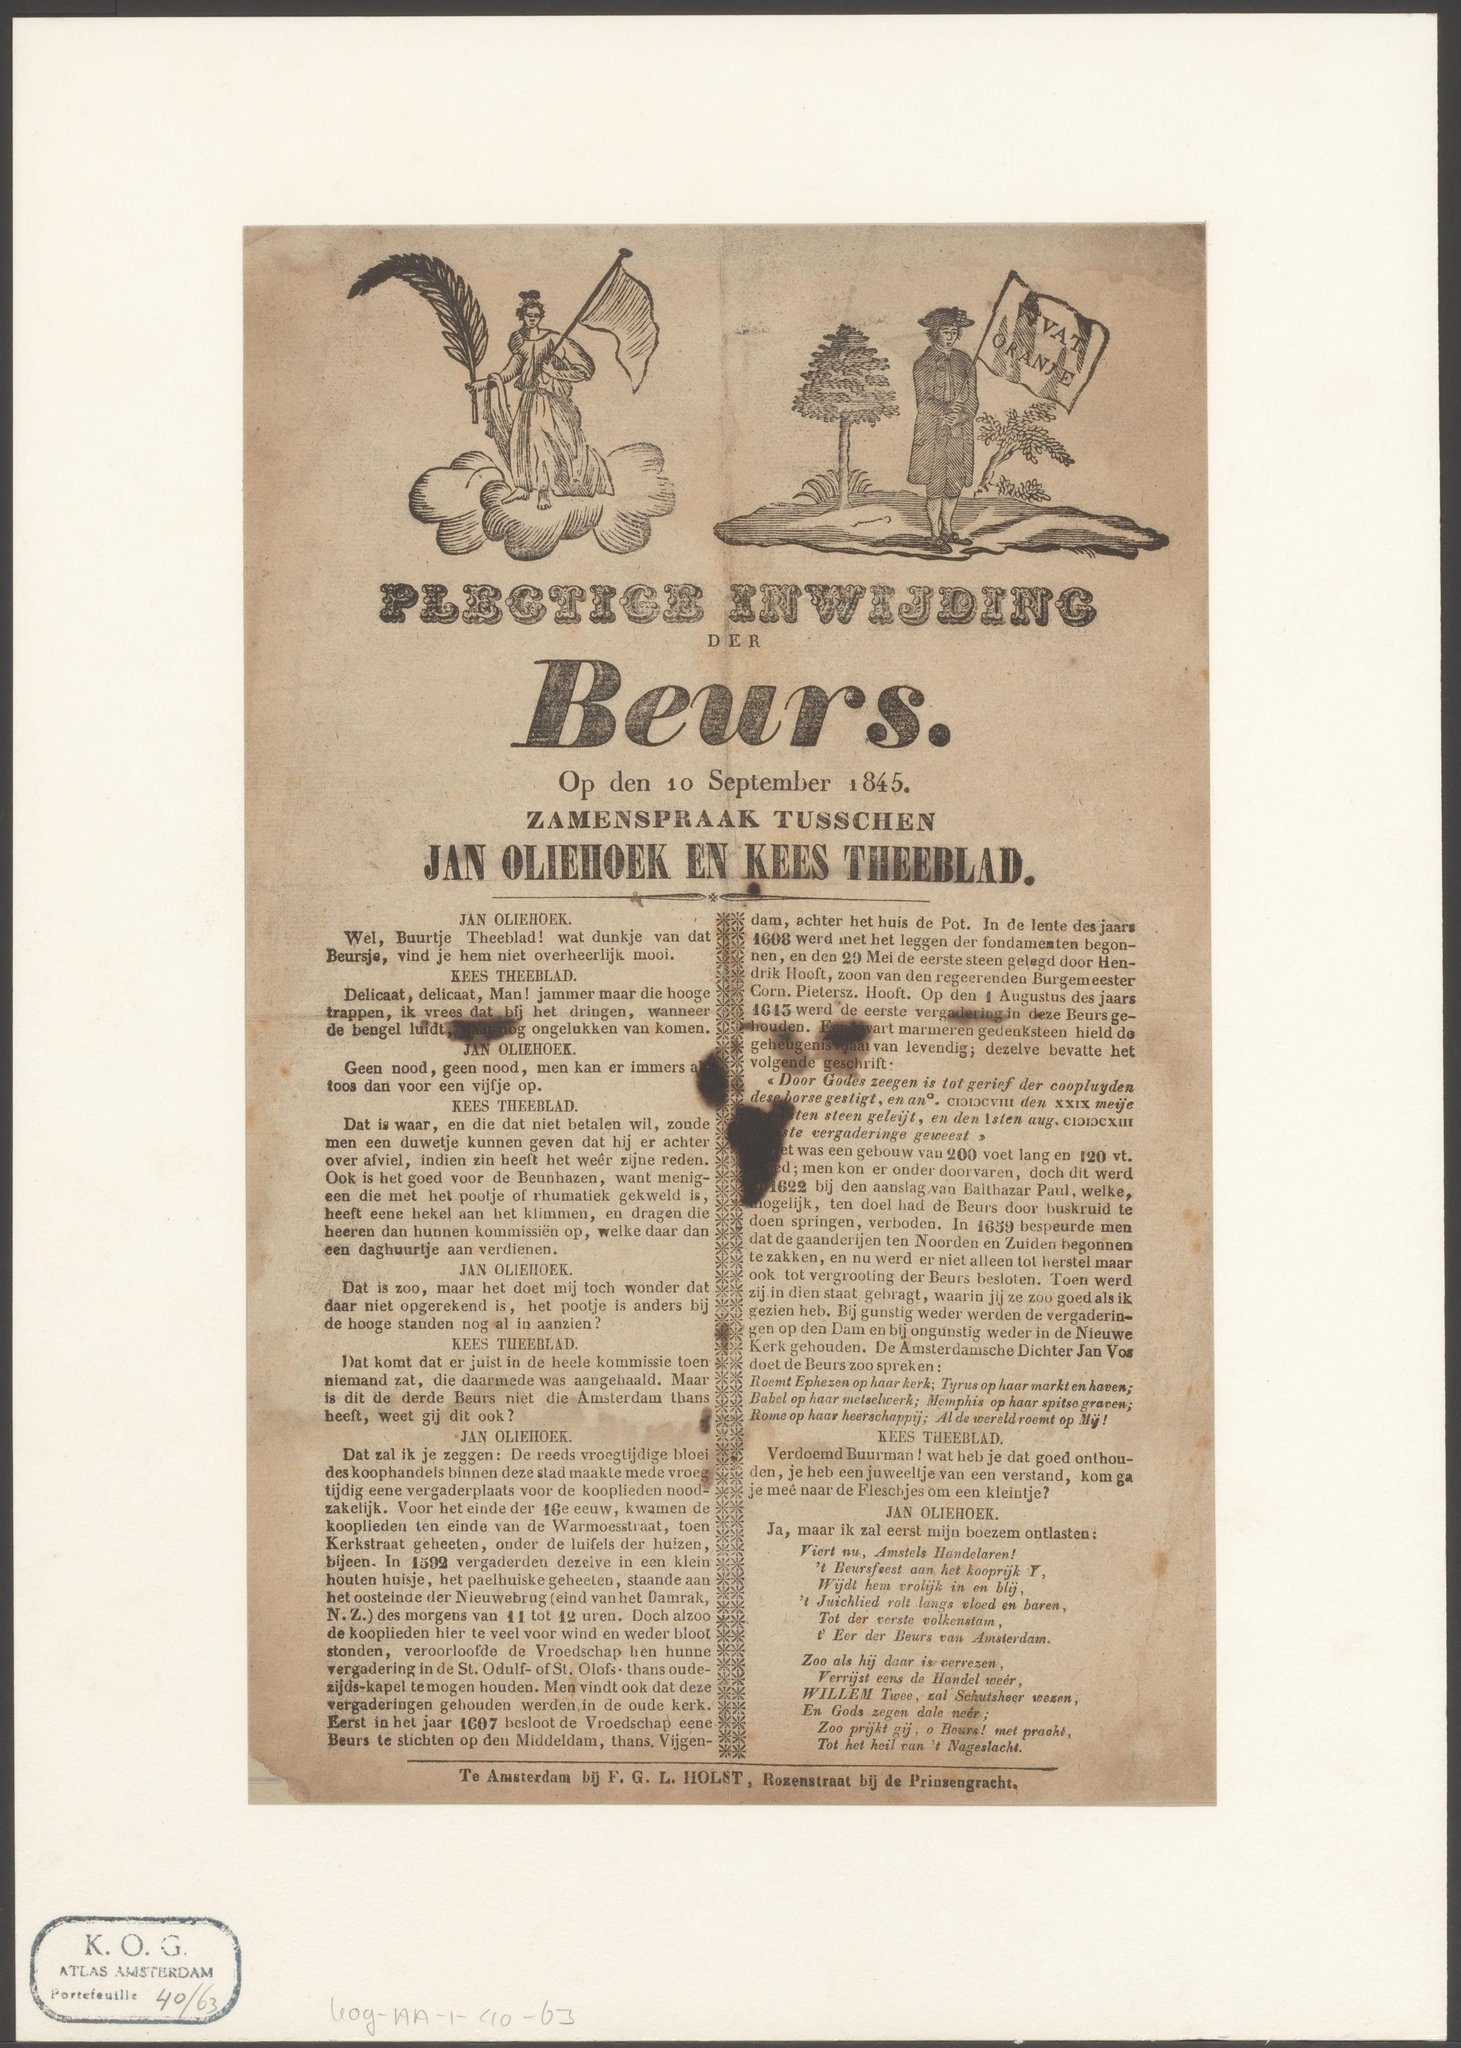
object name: text sheet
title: Plegtige inwijding der Beurs. Op den 10 September 1845. Zamenspraak tusschen Jan Oliehoek en Kees Theeblad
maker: fredrik george lodewijk holst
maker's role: printer, publisher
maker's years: 1803-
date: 1845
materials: paper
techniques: letterpress printing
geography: amsterdam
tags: stock exchange, stock-market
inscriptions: collector's mark: Lugt 1641b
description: Fictief dialoog tussen Jan Oliehoek en Kees Theeblad over de inwijding van de Beurs van Zocher te Amsterdam. Linksboven een vrouw op een wolk met een palmtak en een vaandel en rechtsboven een man in een landschap met een vlag waarop een Oranjegezinde leuze staat. Onderwerpsrubriek binnen de Atlas Amsterdam: Handel en Zeevaart: Hulpbeurs op de Dam en Beurs (Dam).